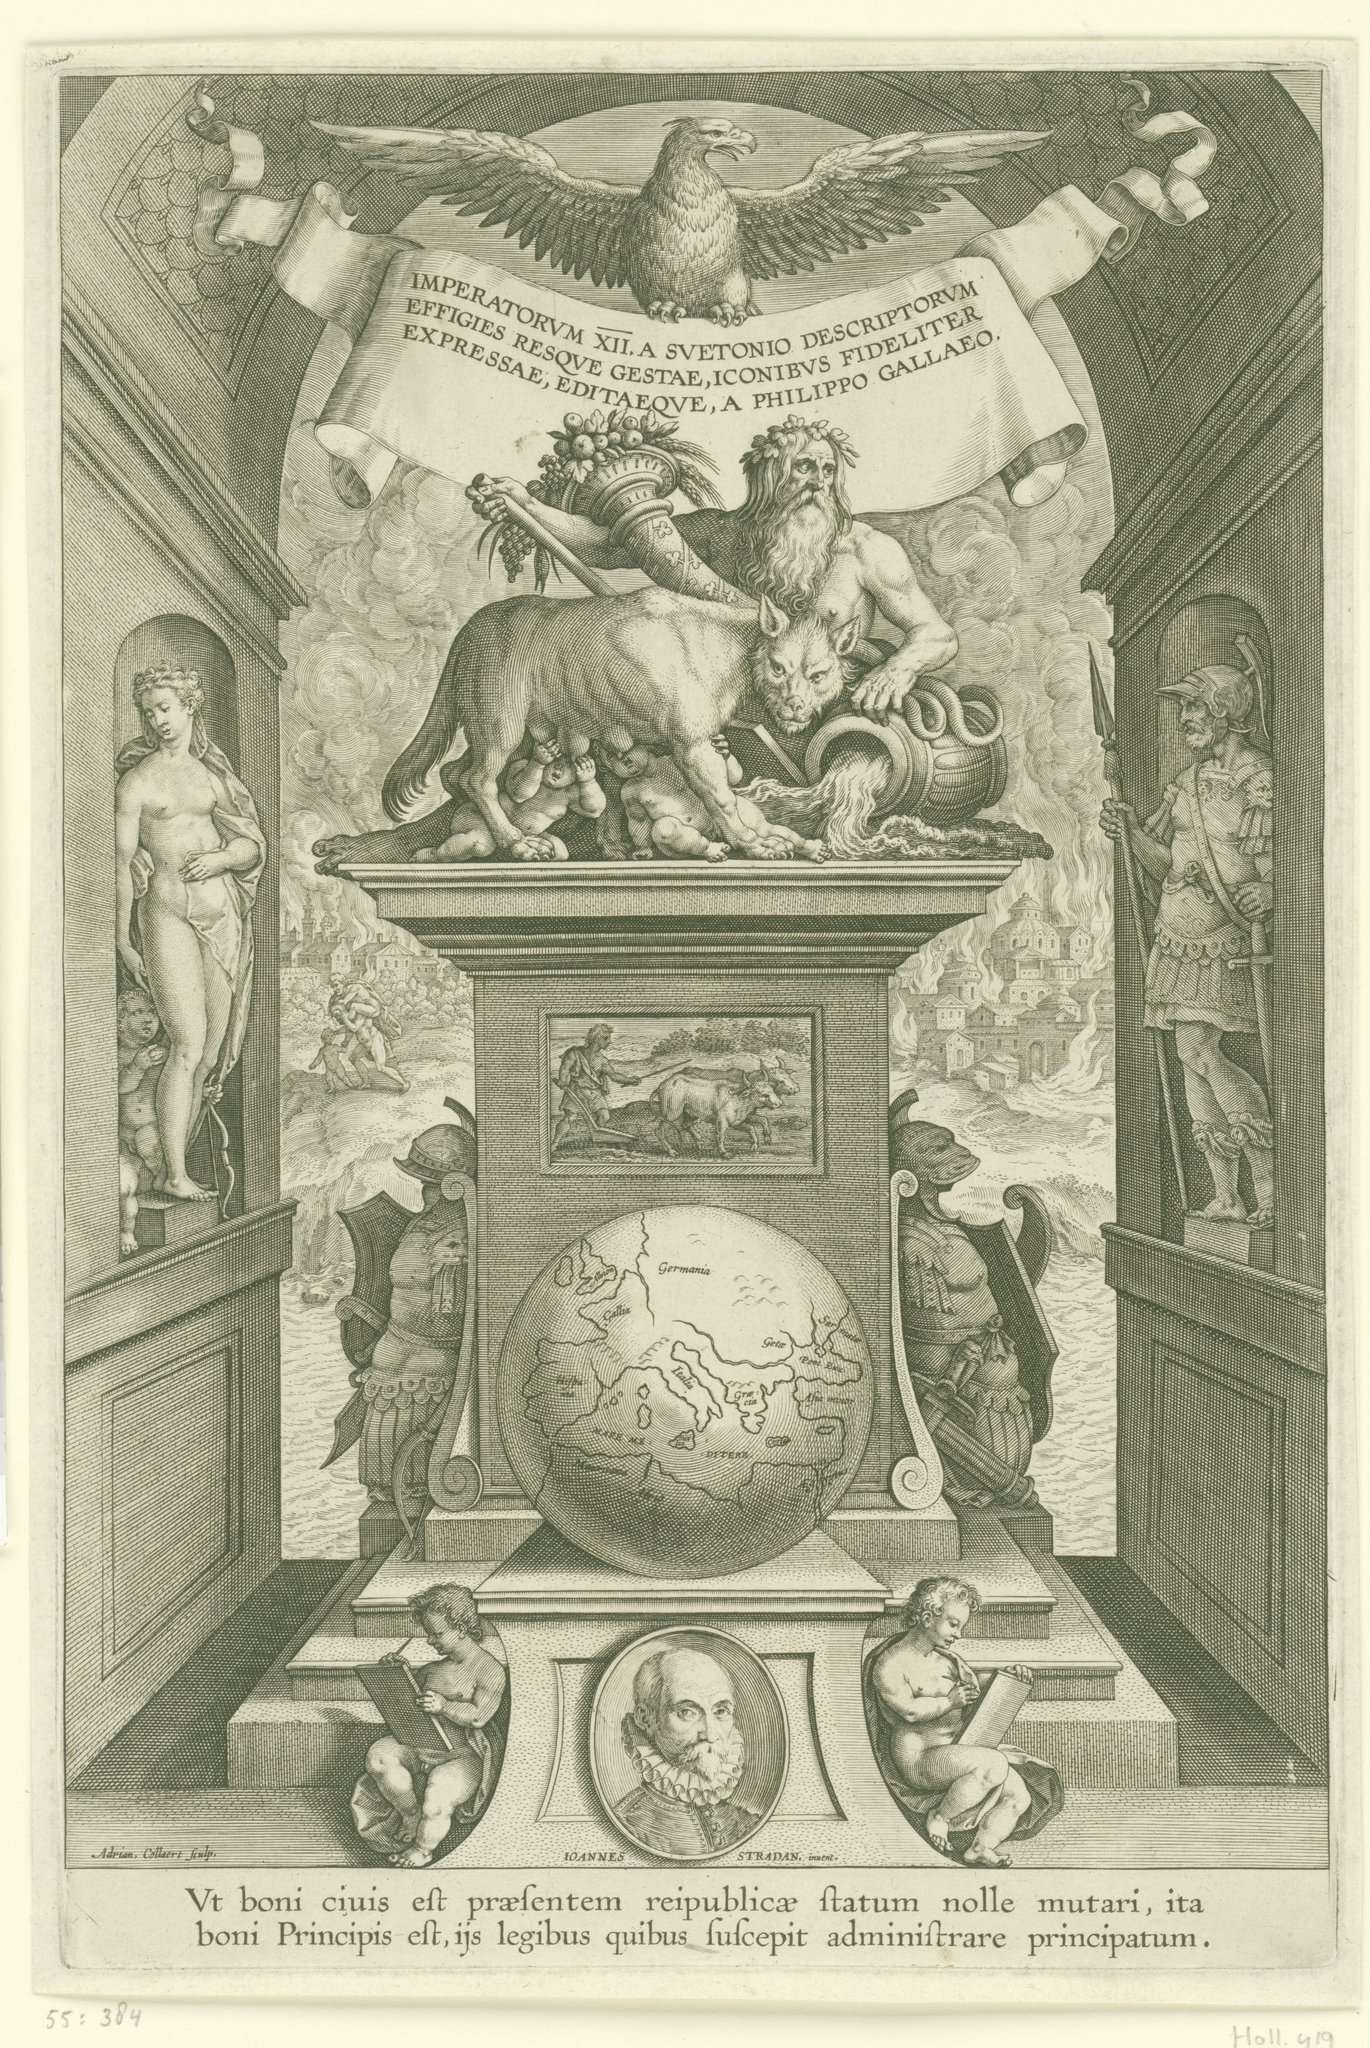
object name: titelprent, frontispice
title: Titelprent van een serie over Romeinse keizers te paard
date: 1587-1589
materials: paper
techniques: engraving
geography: antwerp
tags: draughtsman, jan van der straet, (story of) diana (artemis), (story of) mars (ares), 'pius aeneas': aeneas, leading ascanius, escapes from burning troy, carrying his father anchises with the penates; his wife creusa, who sets out with them, is lost on the way, romulus and remus are washed ashore and suckled by a she-wolf; 'lupa romana', personification of river tiber; 'tevere' (ripa), globe, (map of) europe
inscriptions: collector's mark: Lugt 2542, collector's mark: Lugt 2228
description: Centraal in deze titelprent een kolom met bovenop het symbool van Rome, de wolvin die de tweeling Romulus en Remus zoogt. Naast haar de personificatie van De Tiber. Boven hen vliegt een adelaar, met in zijn klauwen een cartouche met de titel van de serie. Onderaan de kolom de wereldbol met het Romeinse Rijk en het portret van Johannes Stradanus in een ovale lijst met buste naar rechts. Aan weerszijden de goden Diana en Mars. Op de achtergrond de verwoesting van Troje en de vlucht van Aeneas met zijn vader op zijn rug en zijn zoontje in de hand. De prent heeft een Latijns onderschrift. Dit is de titelprent van een twaalfdelige serie over Romeinse keizers.